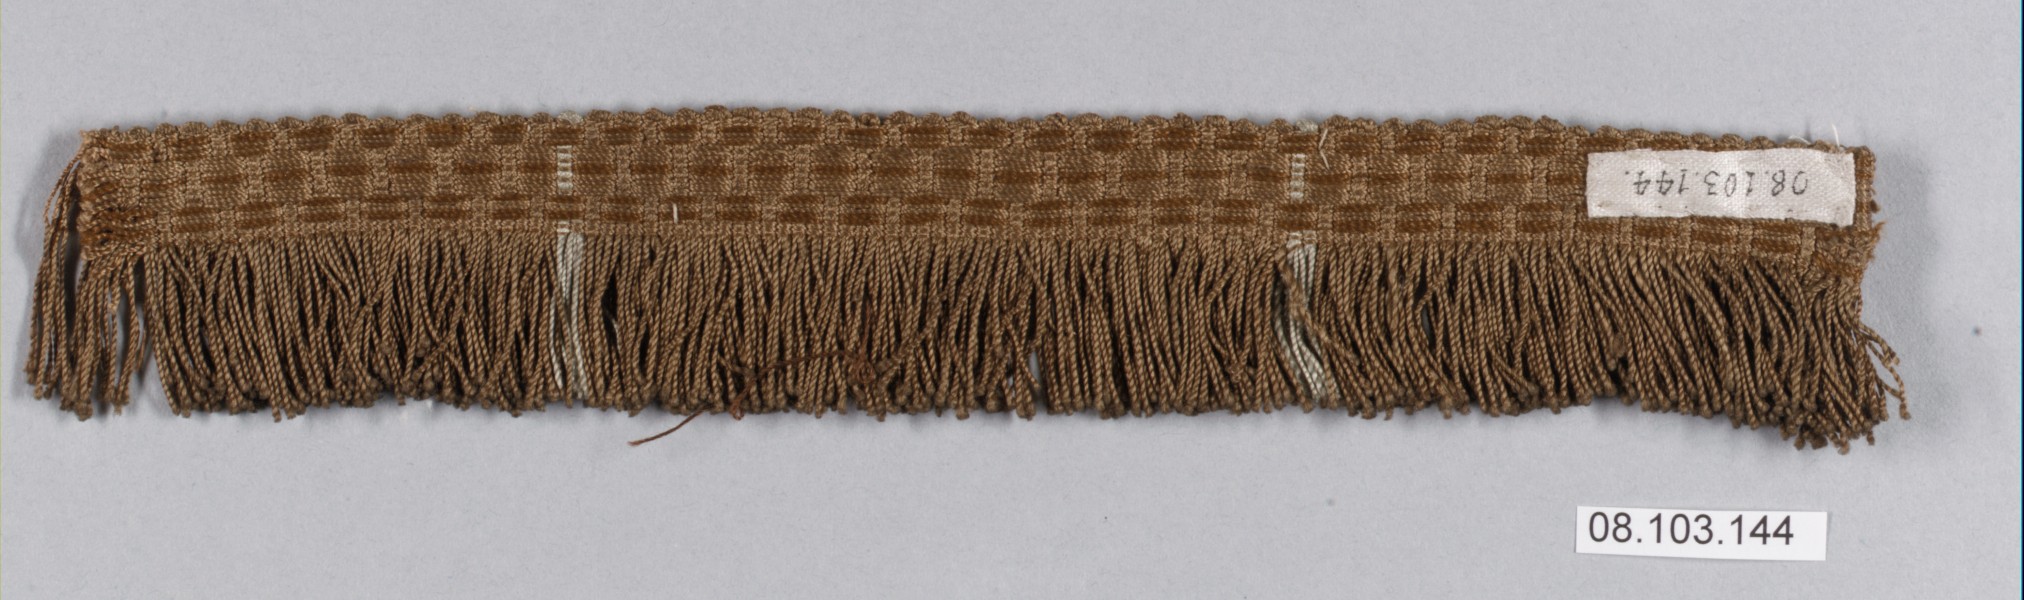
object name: fringe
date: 1801-1900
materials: silk